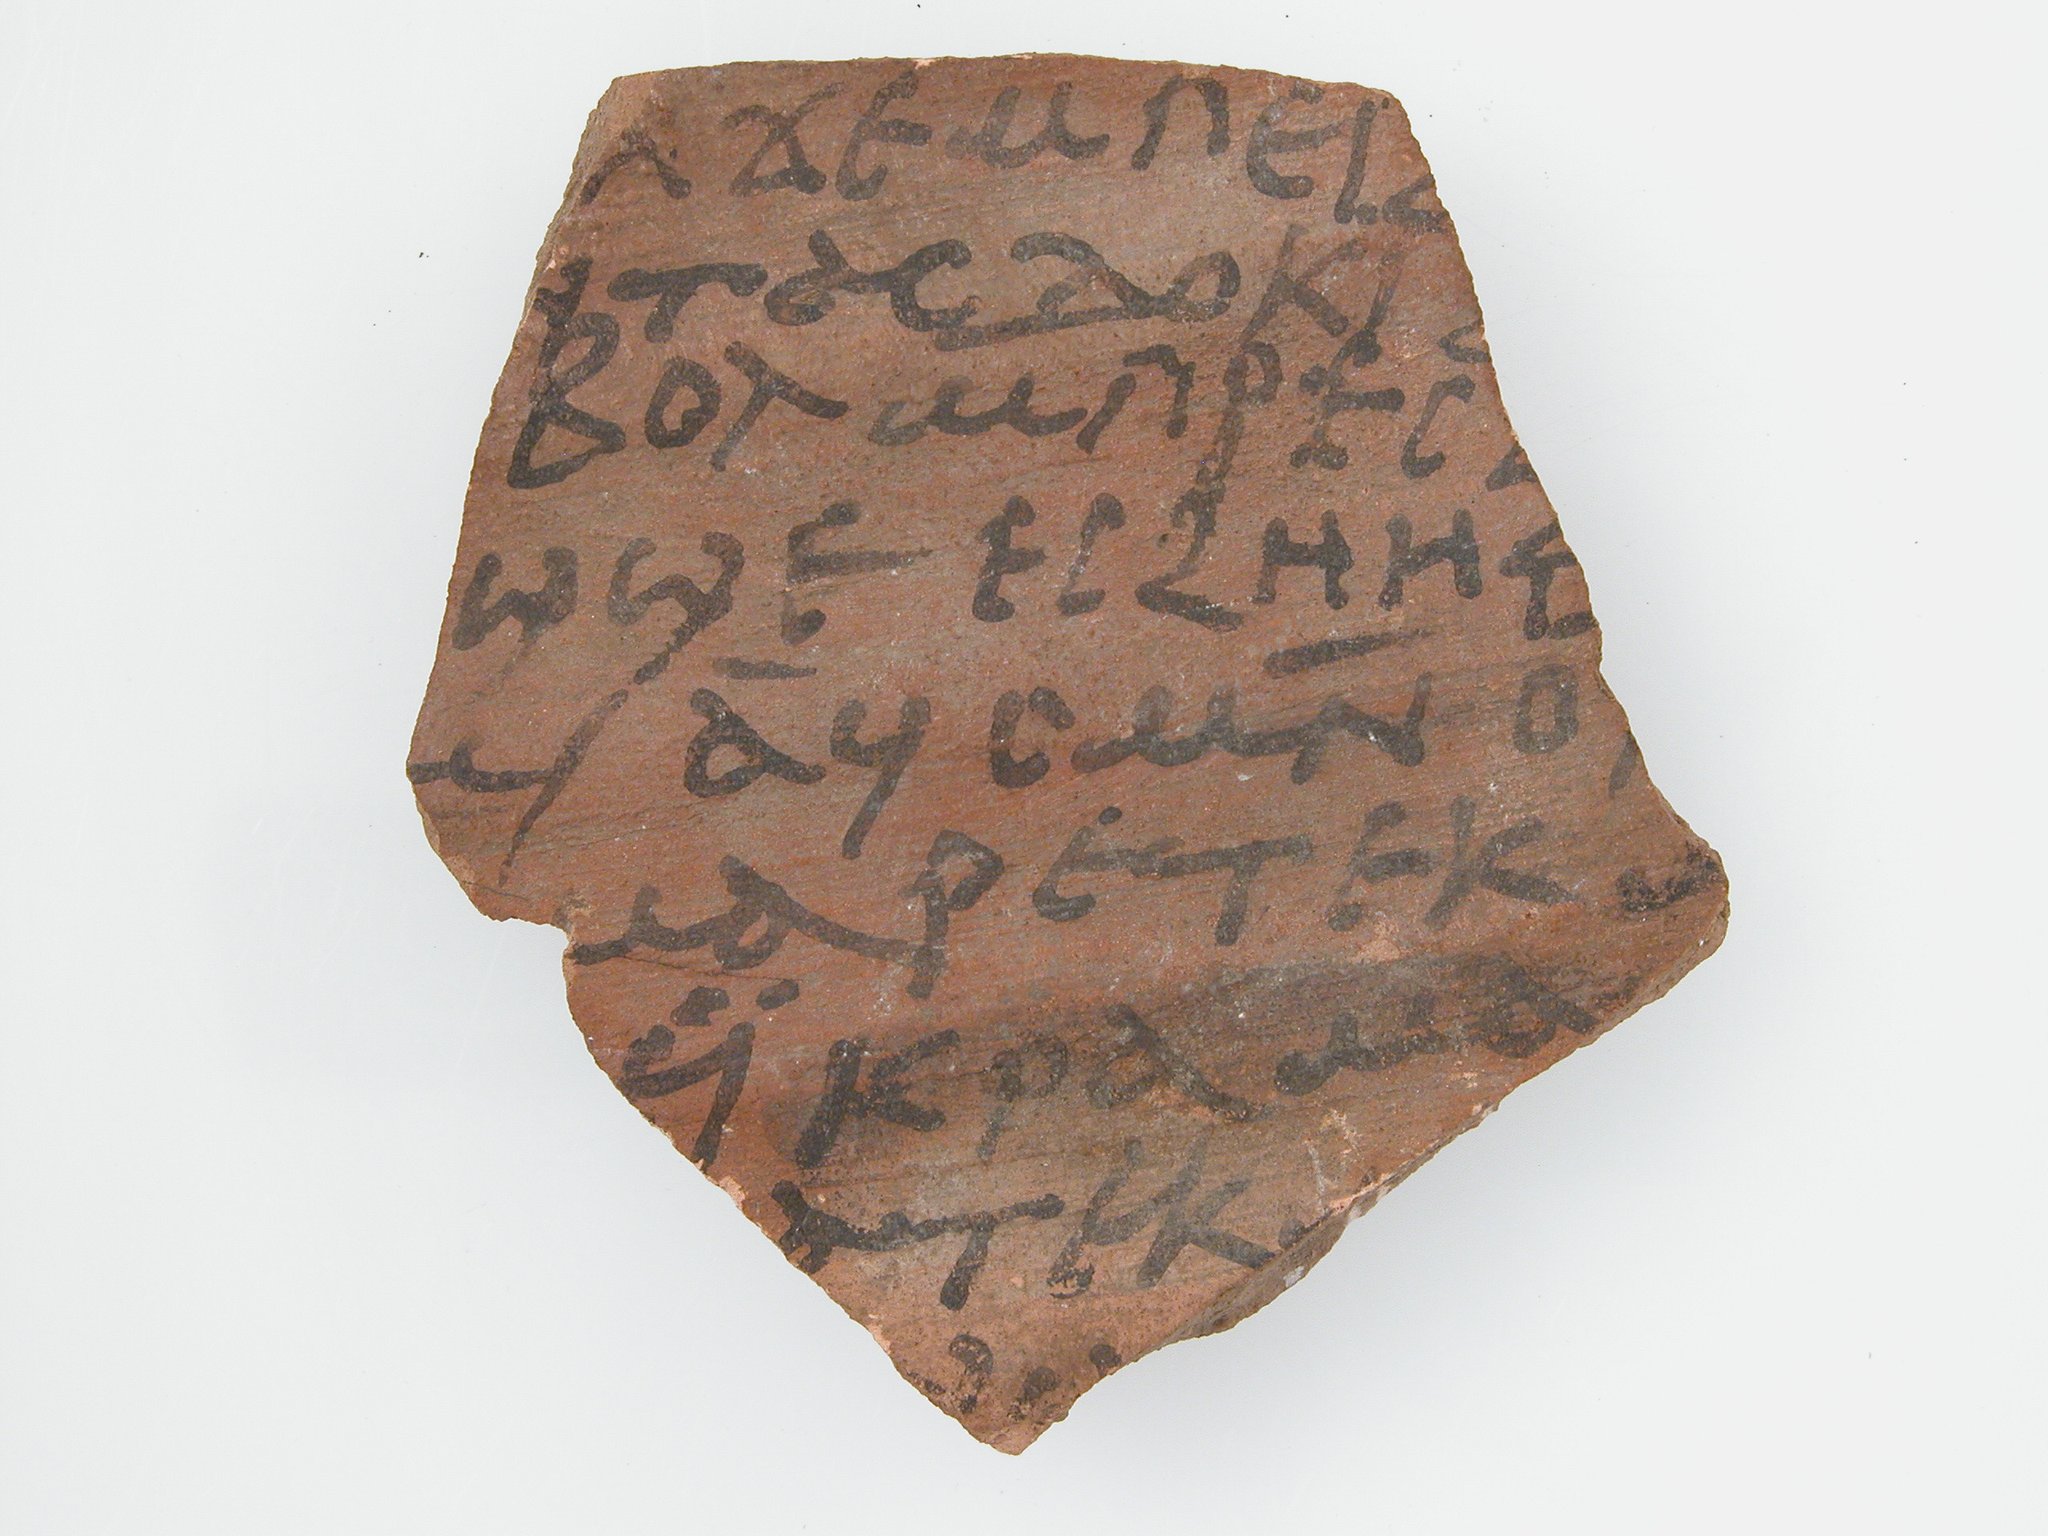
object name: ostrakon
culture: coptic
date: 580-640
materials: ink, pottery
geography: egypt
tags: coptic,documents